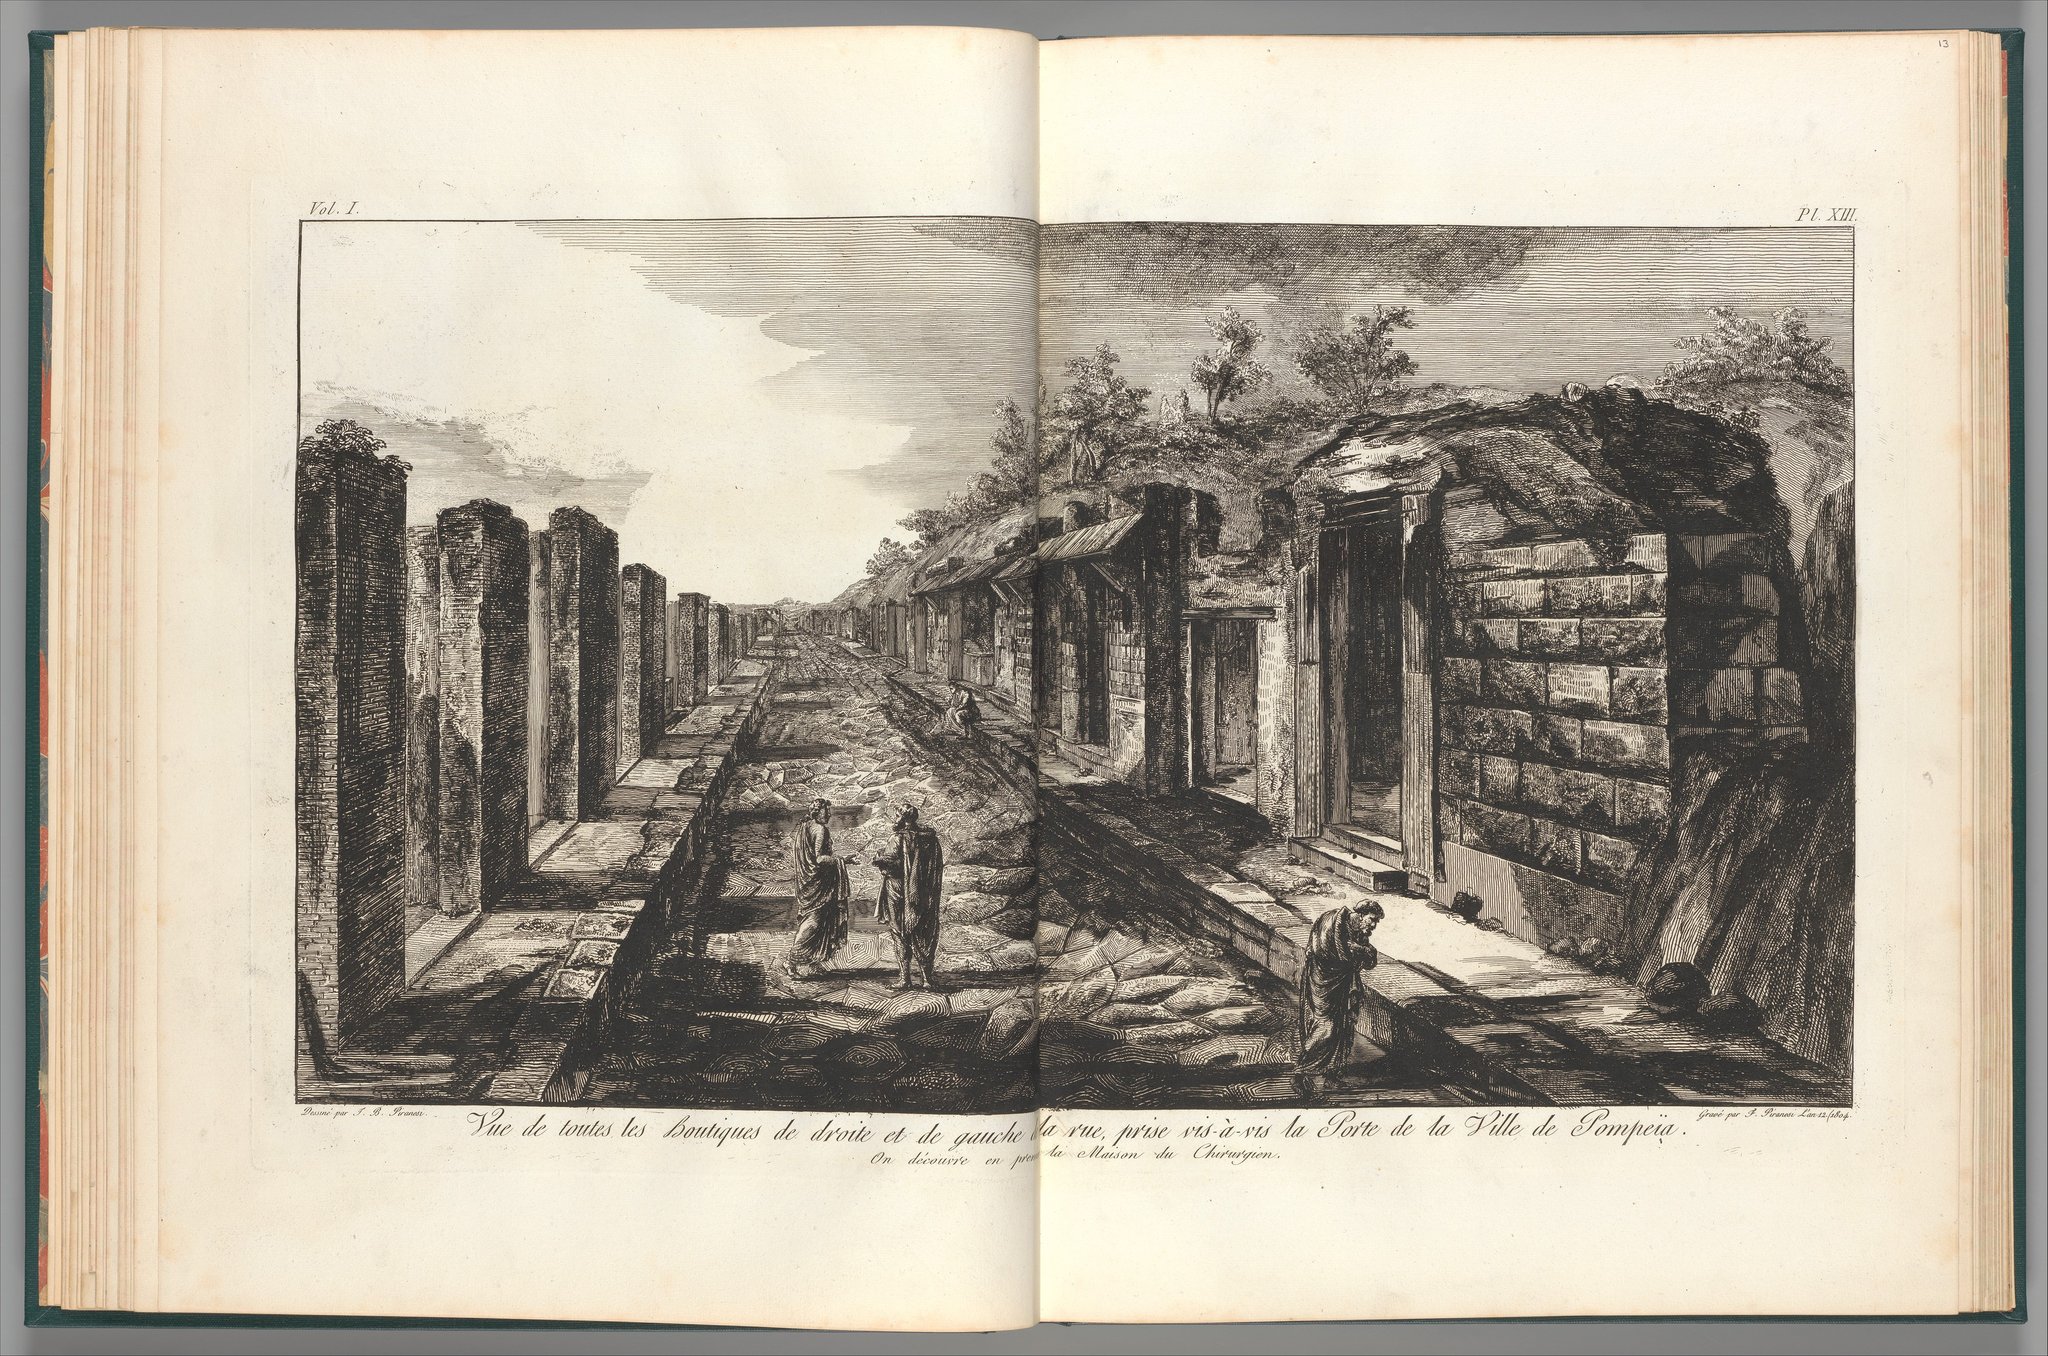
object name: print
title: View opposite the entrance gate of all of the shops to the right and left of the street of the City of Pompeii, from "Antiquités de Pompeïa, tome premier, Antiquités de la Grande Grèce..." (Antiquities of Pompeii, volume one, Antiquities of Great Greece...), volume 1, plate 13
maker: francesco piranesi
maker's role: artist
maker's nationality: italian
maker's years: 1758-1810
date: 1804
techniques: etching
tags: buildings,men,women